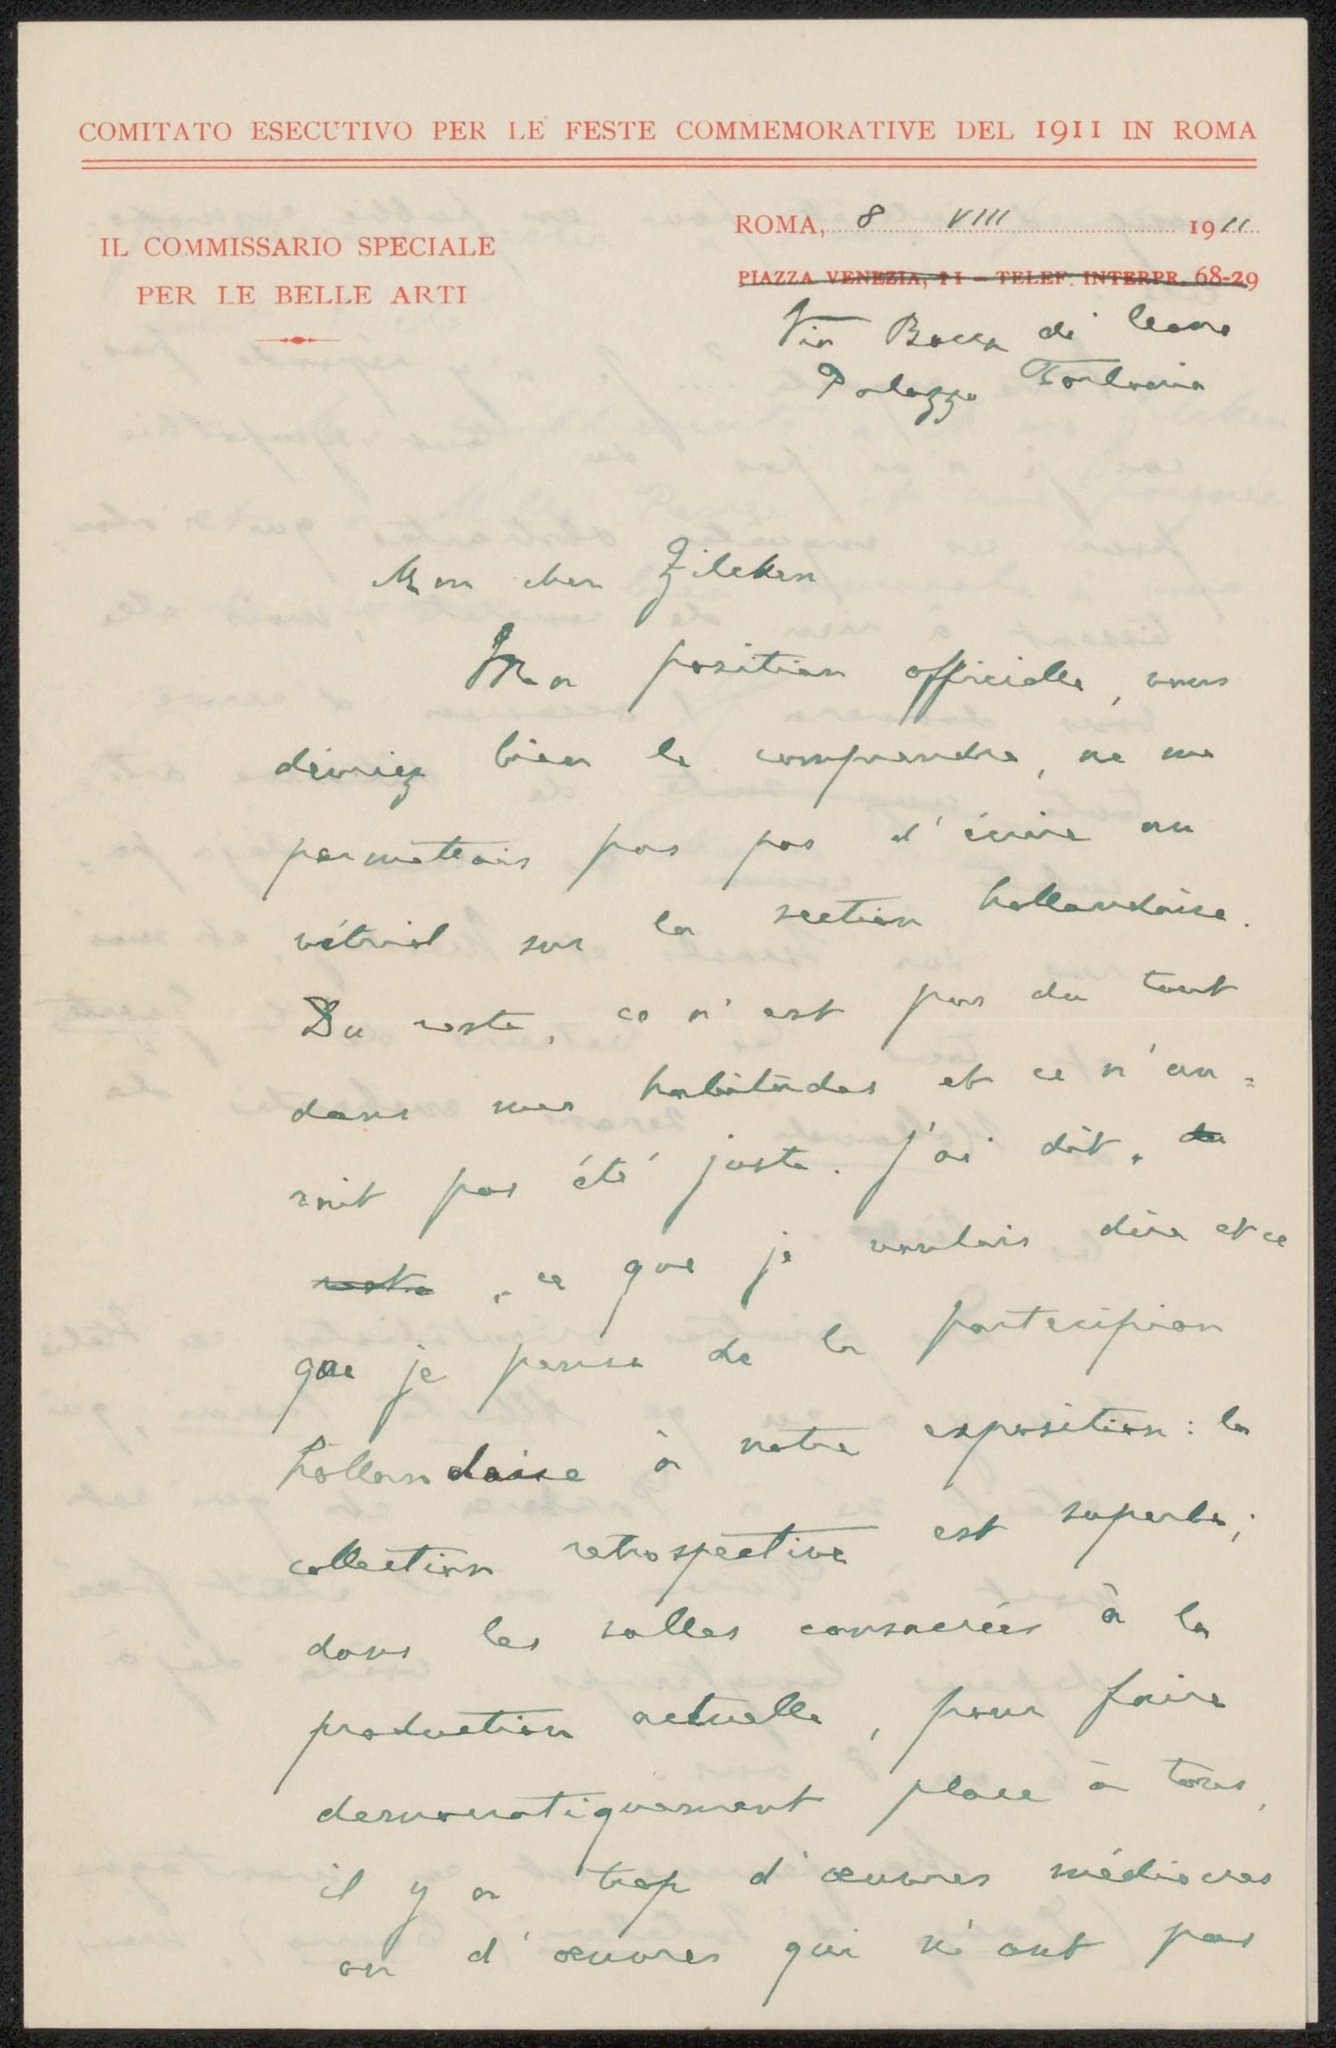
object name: letter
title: Brief aan Philip Zilcken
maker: vittorio pica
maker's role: criticus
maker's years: 1864-1930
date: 1911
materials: ink, paper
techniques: pen, printing, writing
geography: rome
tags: the hague, print maker, draughtsman, jozef israëls, hendrik willem mesdag, alberto pasini, philip zilcken, exhibition ~ art, rome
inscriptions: collector's mark: ‘RPK’, watermark